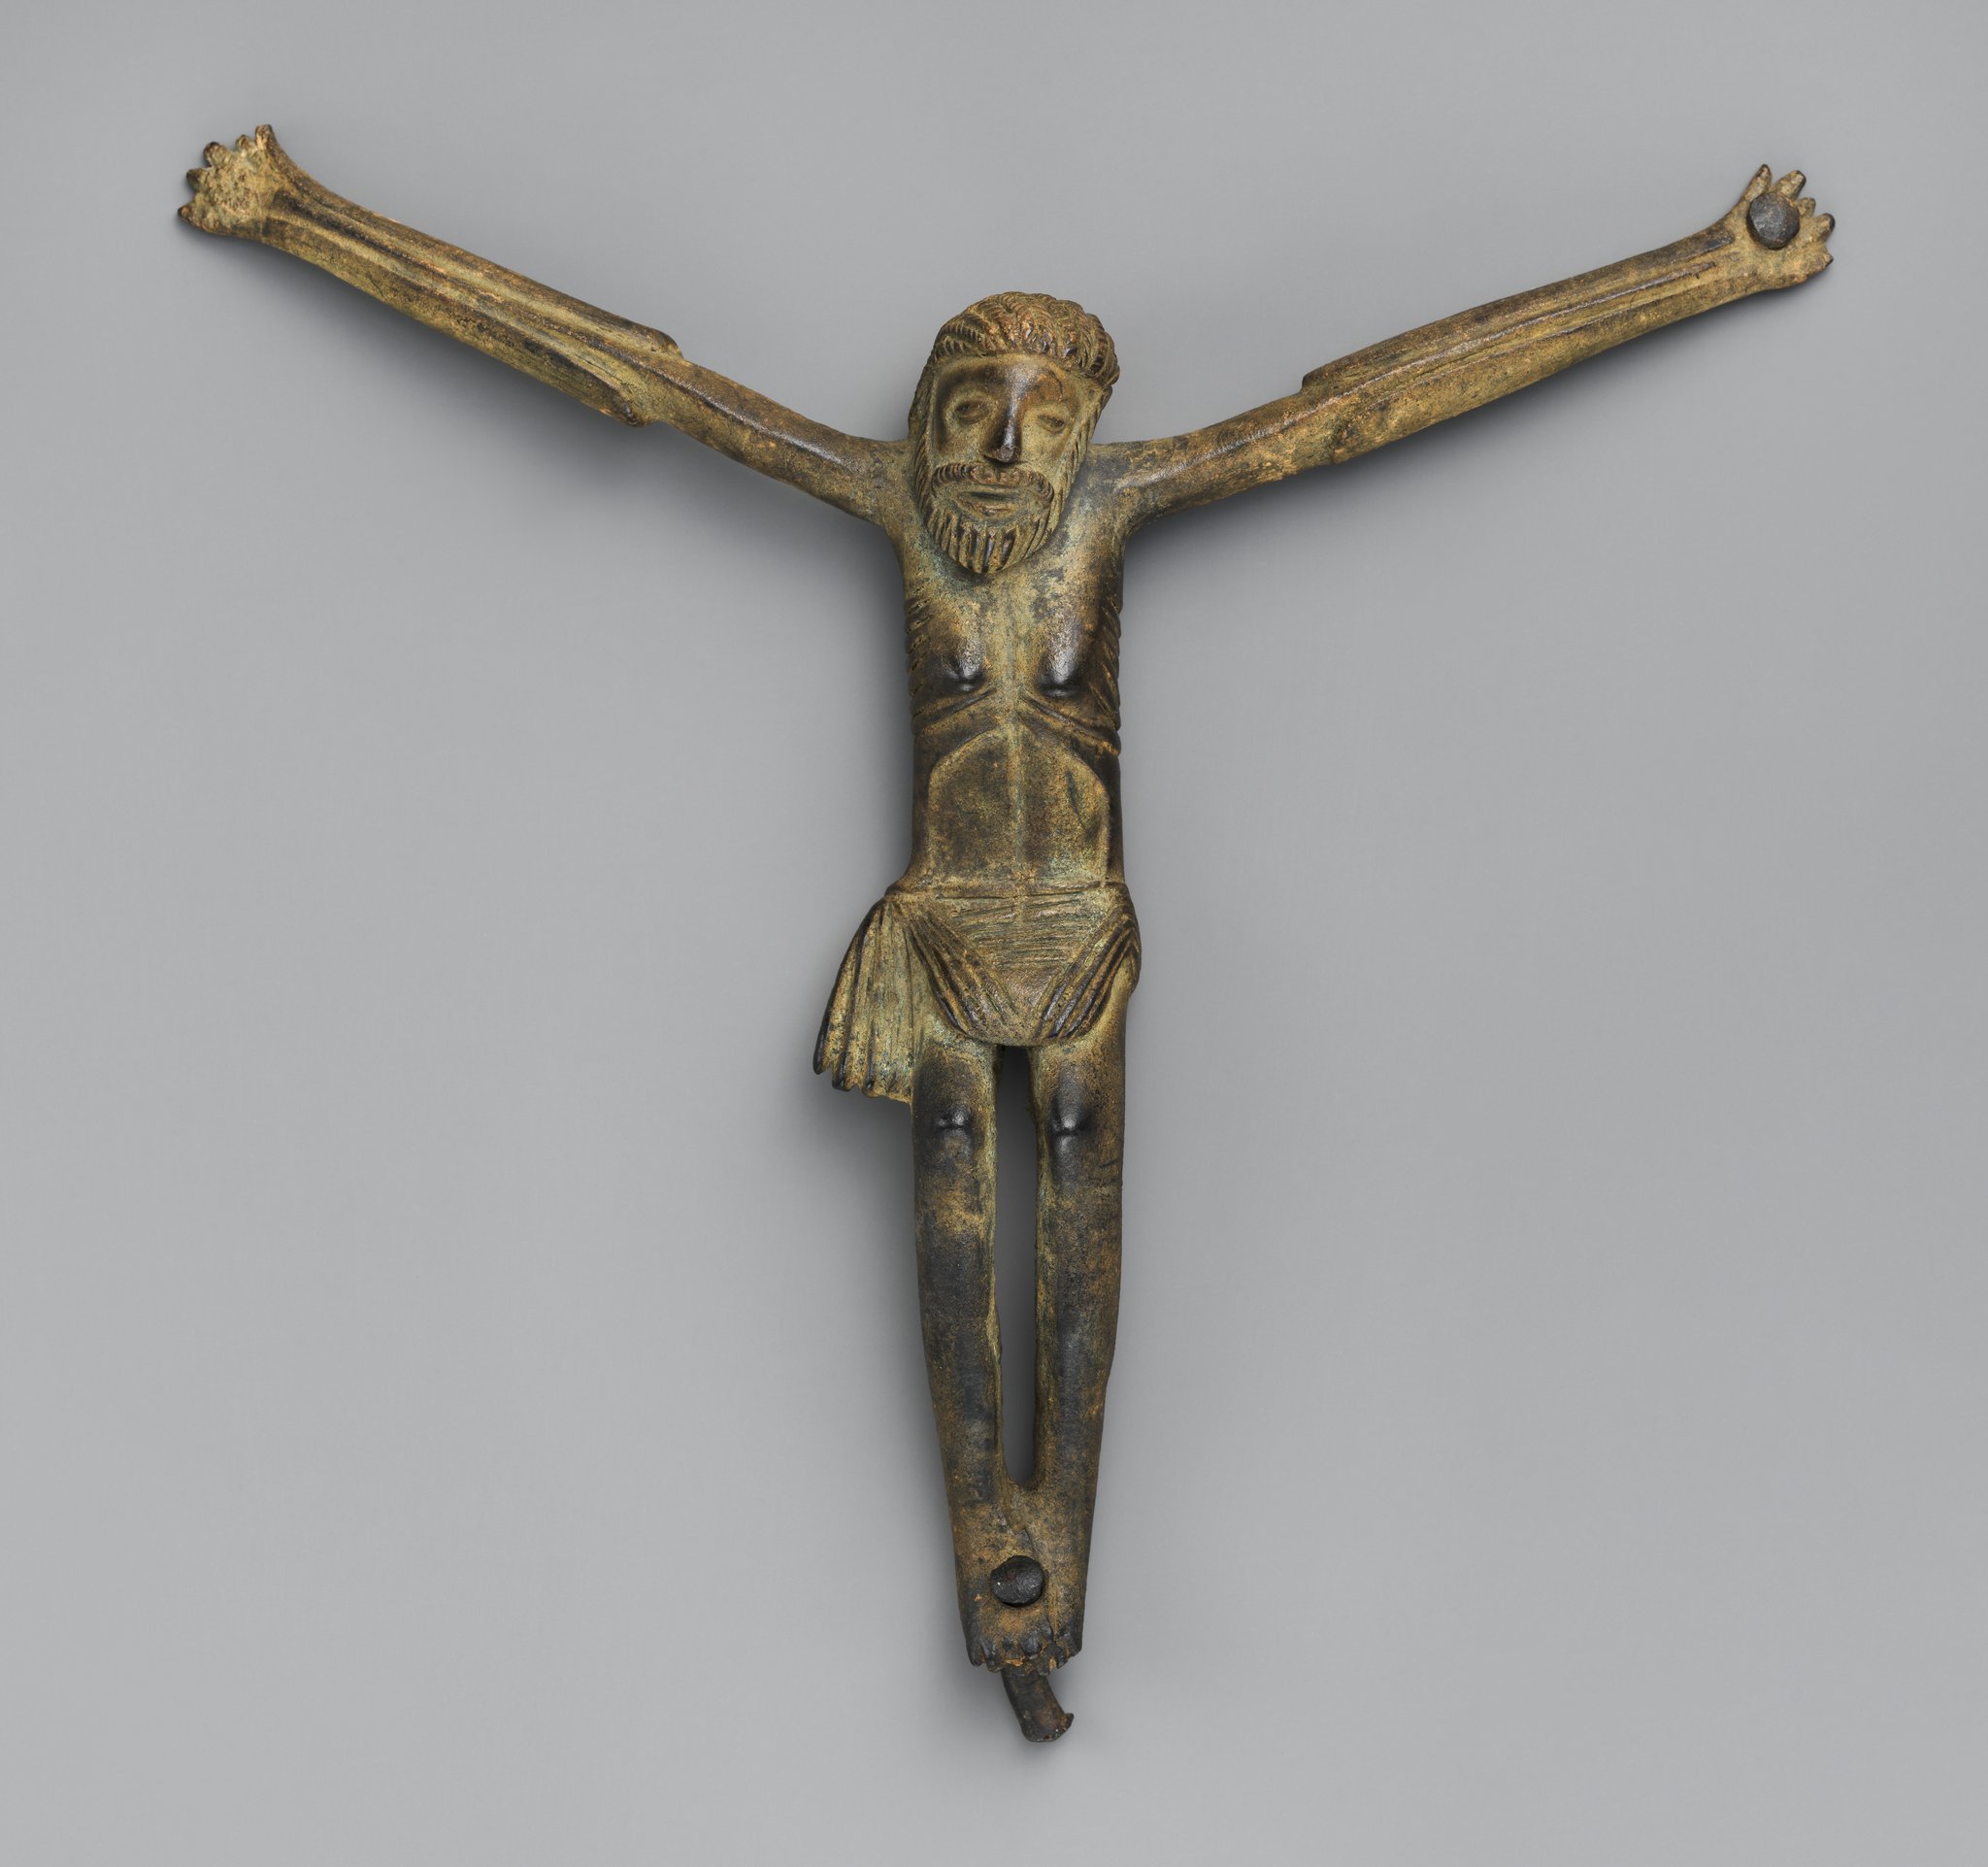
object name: figure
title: Christ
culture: kongo, kongo kingdom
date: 1701-1900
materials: brass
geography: angola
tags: christ